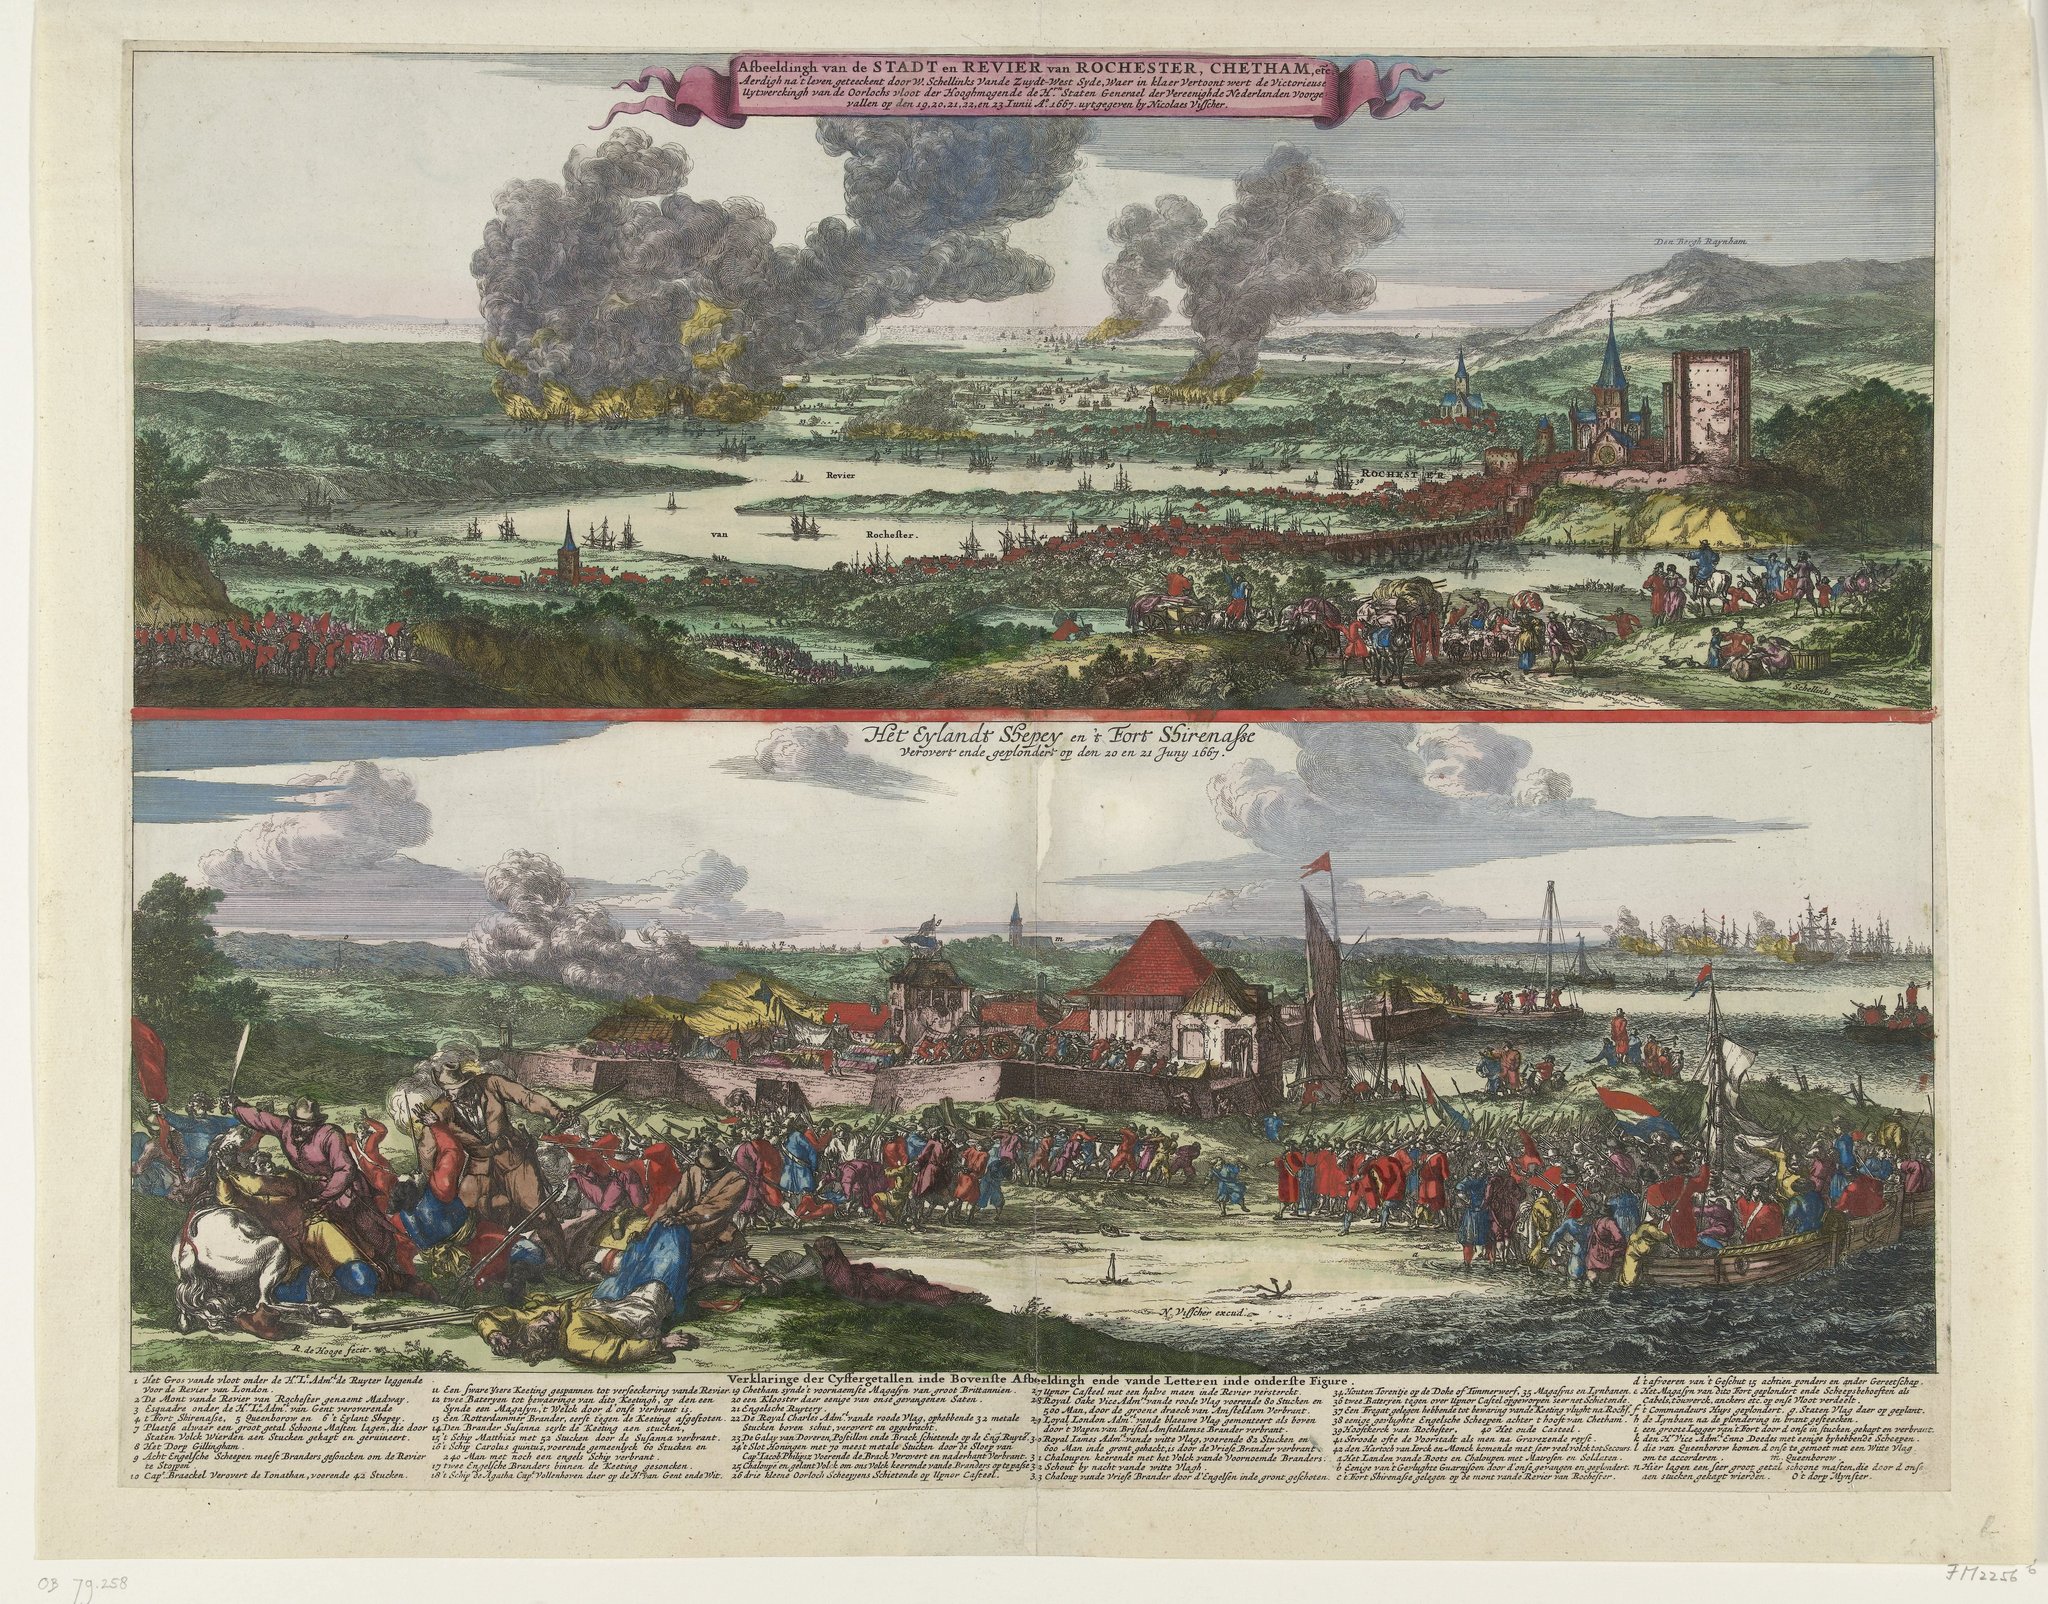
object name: print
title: Tocht naar Chatham en de verovering van het eiland Sheppey, 1667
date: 1667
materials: paper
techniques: etching, hand coloring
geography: amsterdam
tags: flushing, michiel adriaenszoon de ruyter, battle (+ naval force), raid on the medway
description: Plaat met twee voorstellingen. Boven een landschappelijke voorstelling van de Tocht naar Chatham en de vernietiging van de Engelse vloot op 20 juni 1667 door de Staatse vloot onder Michiel Adriaenszoon de Ruyter. Onder een voorstelling van de verovering van het eiland Sheppey met het fort en magazijn te Sheerness door de troepen van kolonel Dolman. In het onderschrift de legenda's voor beide platen 1-42 en a-o in het Nederlands.